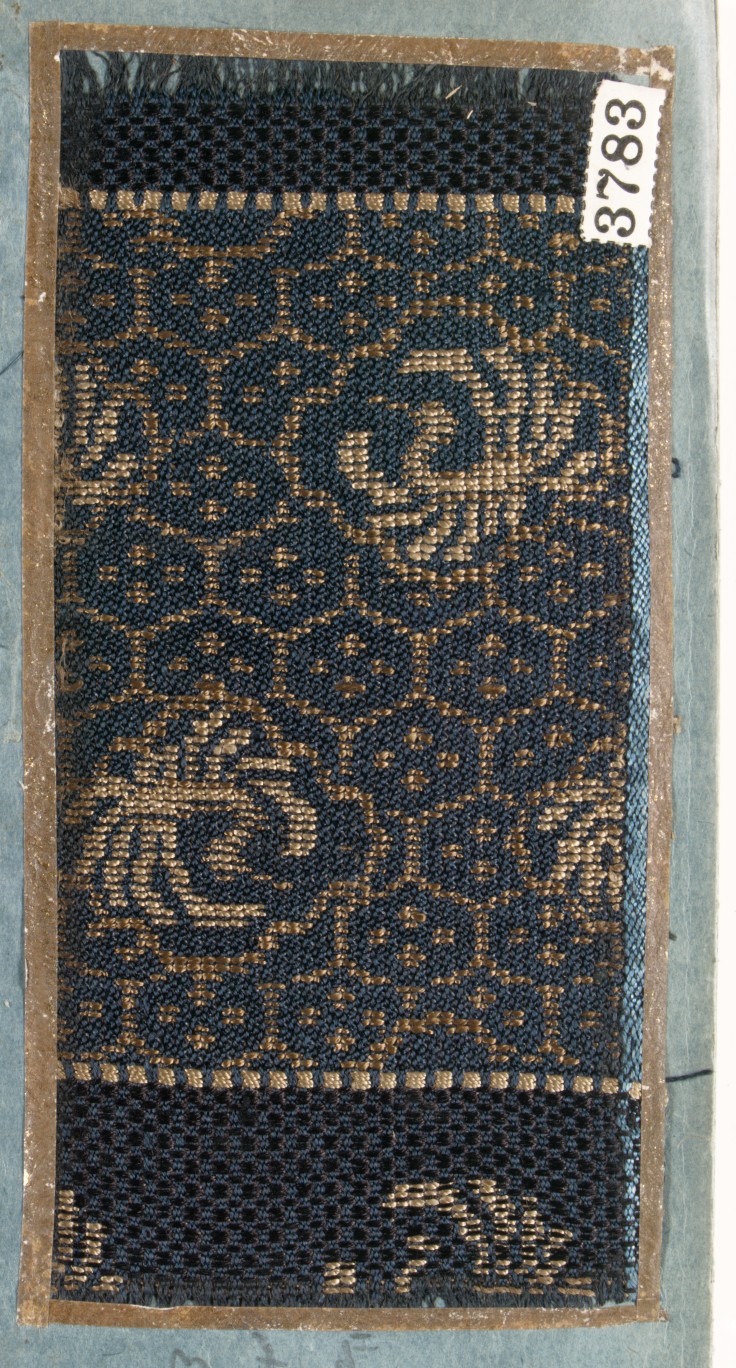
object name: sample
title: Textile Sample from Sample Book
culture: japanese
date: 1801-1900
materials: silk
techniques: tapestry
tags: cranes